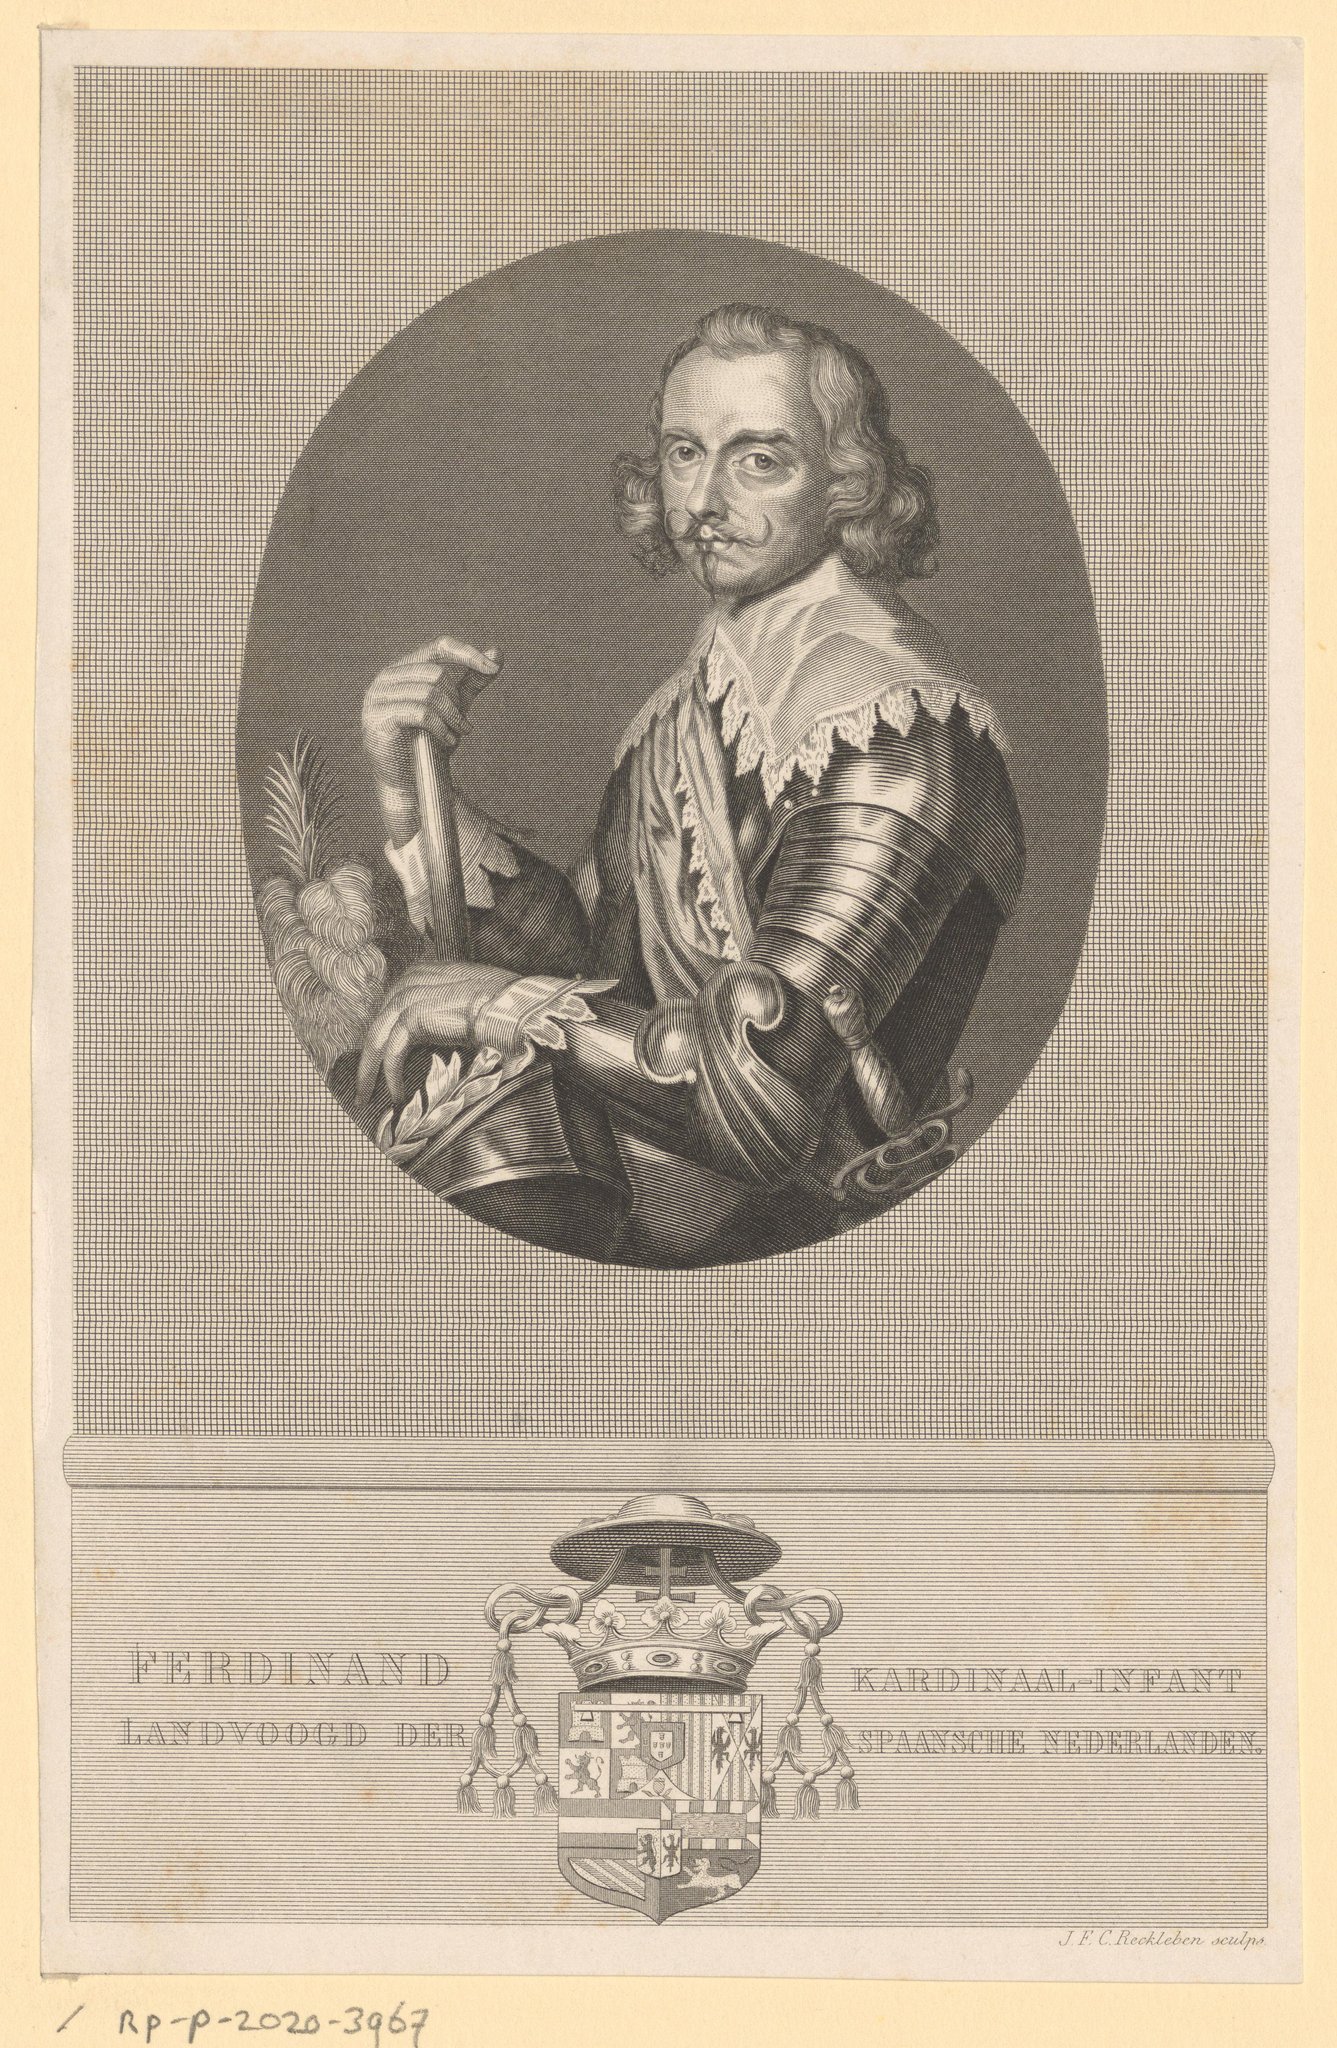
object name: book illustration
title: Portret van Ferdinand van Oostenrijk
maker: jan frederik christiaan reckleben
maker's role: print maker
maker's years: 1819-1879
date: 1868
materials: paper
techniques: engraving, etching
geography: amsterdam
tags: landvoogd der zuidelijke nederlanden ferdinand van oostenrijk, armour, historical persons, armorial bearing, heraldry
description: Prent waarschijnlijk uit: Arend, Johannes Pieter. Algemeene geschiedenis des vaderlands van de vroegste tijden tot op heden. Amsterdam: C.L. Schleijer & zoon, 1868, dl. 3-5.